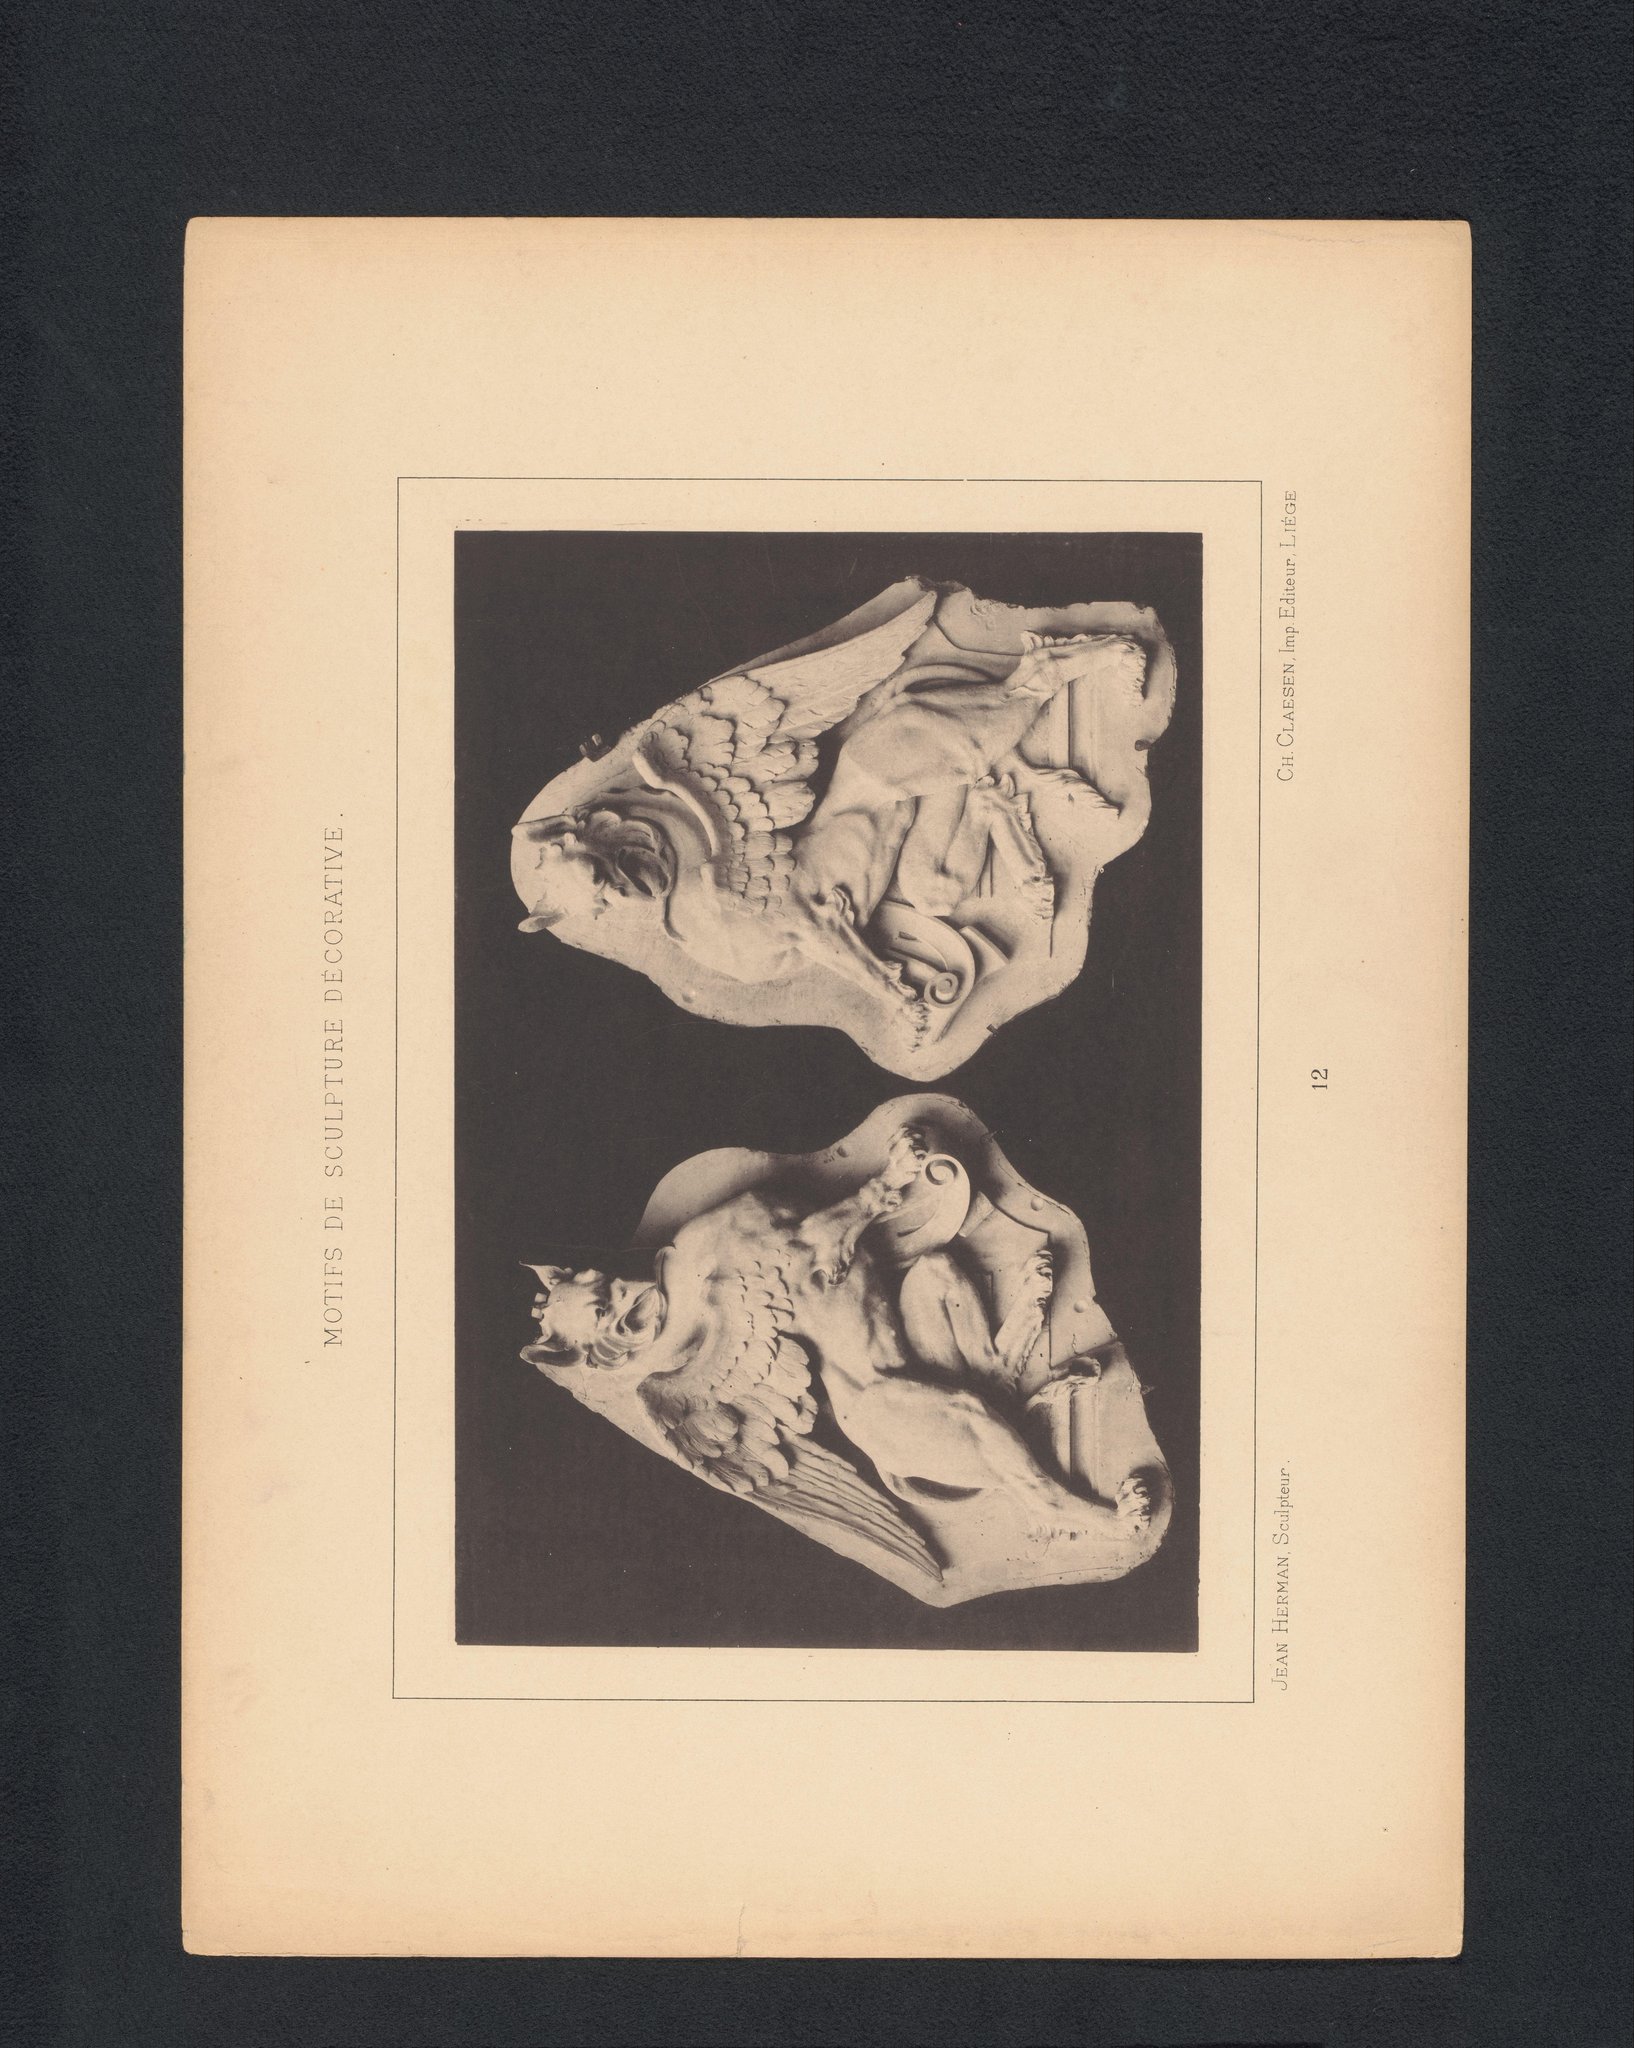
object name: photomechanical print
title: Motifs de sculpture décorative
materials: paper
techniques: photograph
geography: liège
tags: griffin (lion/eagle); 'griffo' (ripa), sculpture (+ relief ~ sculpture)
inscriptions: inscription: ‘Jean Herman, Sculpteur.’, number: ‘12’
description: Deze prent maakt deel uit van een omslag met 28 prenten en een titelblad.